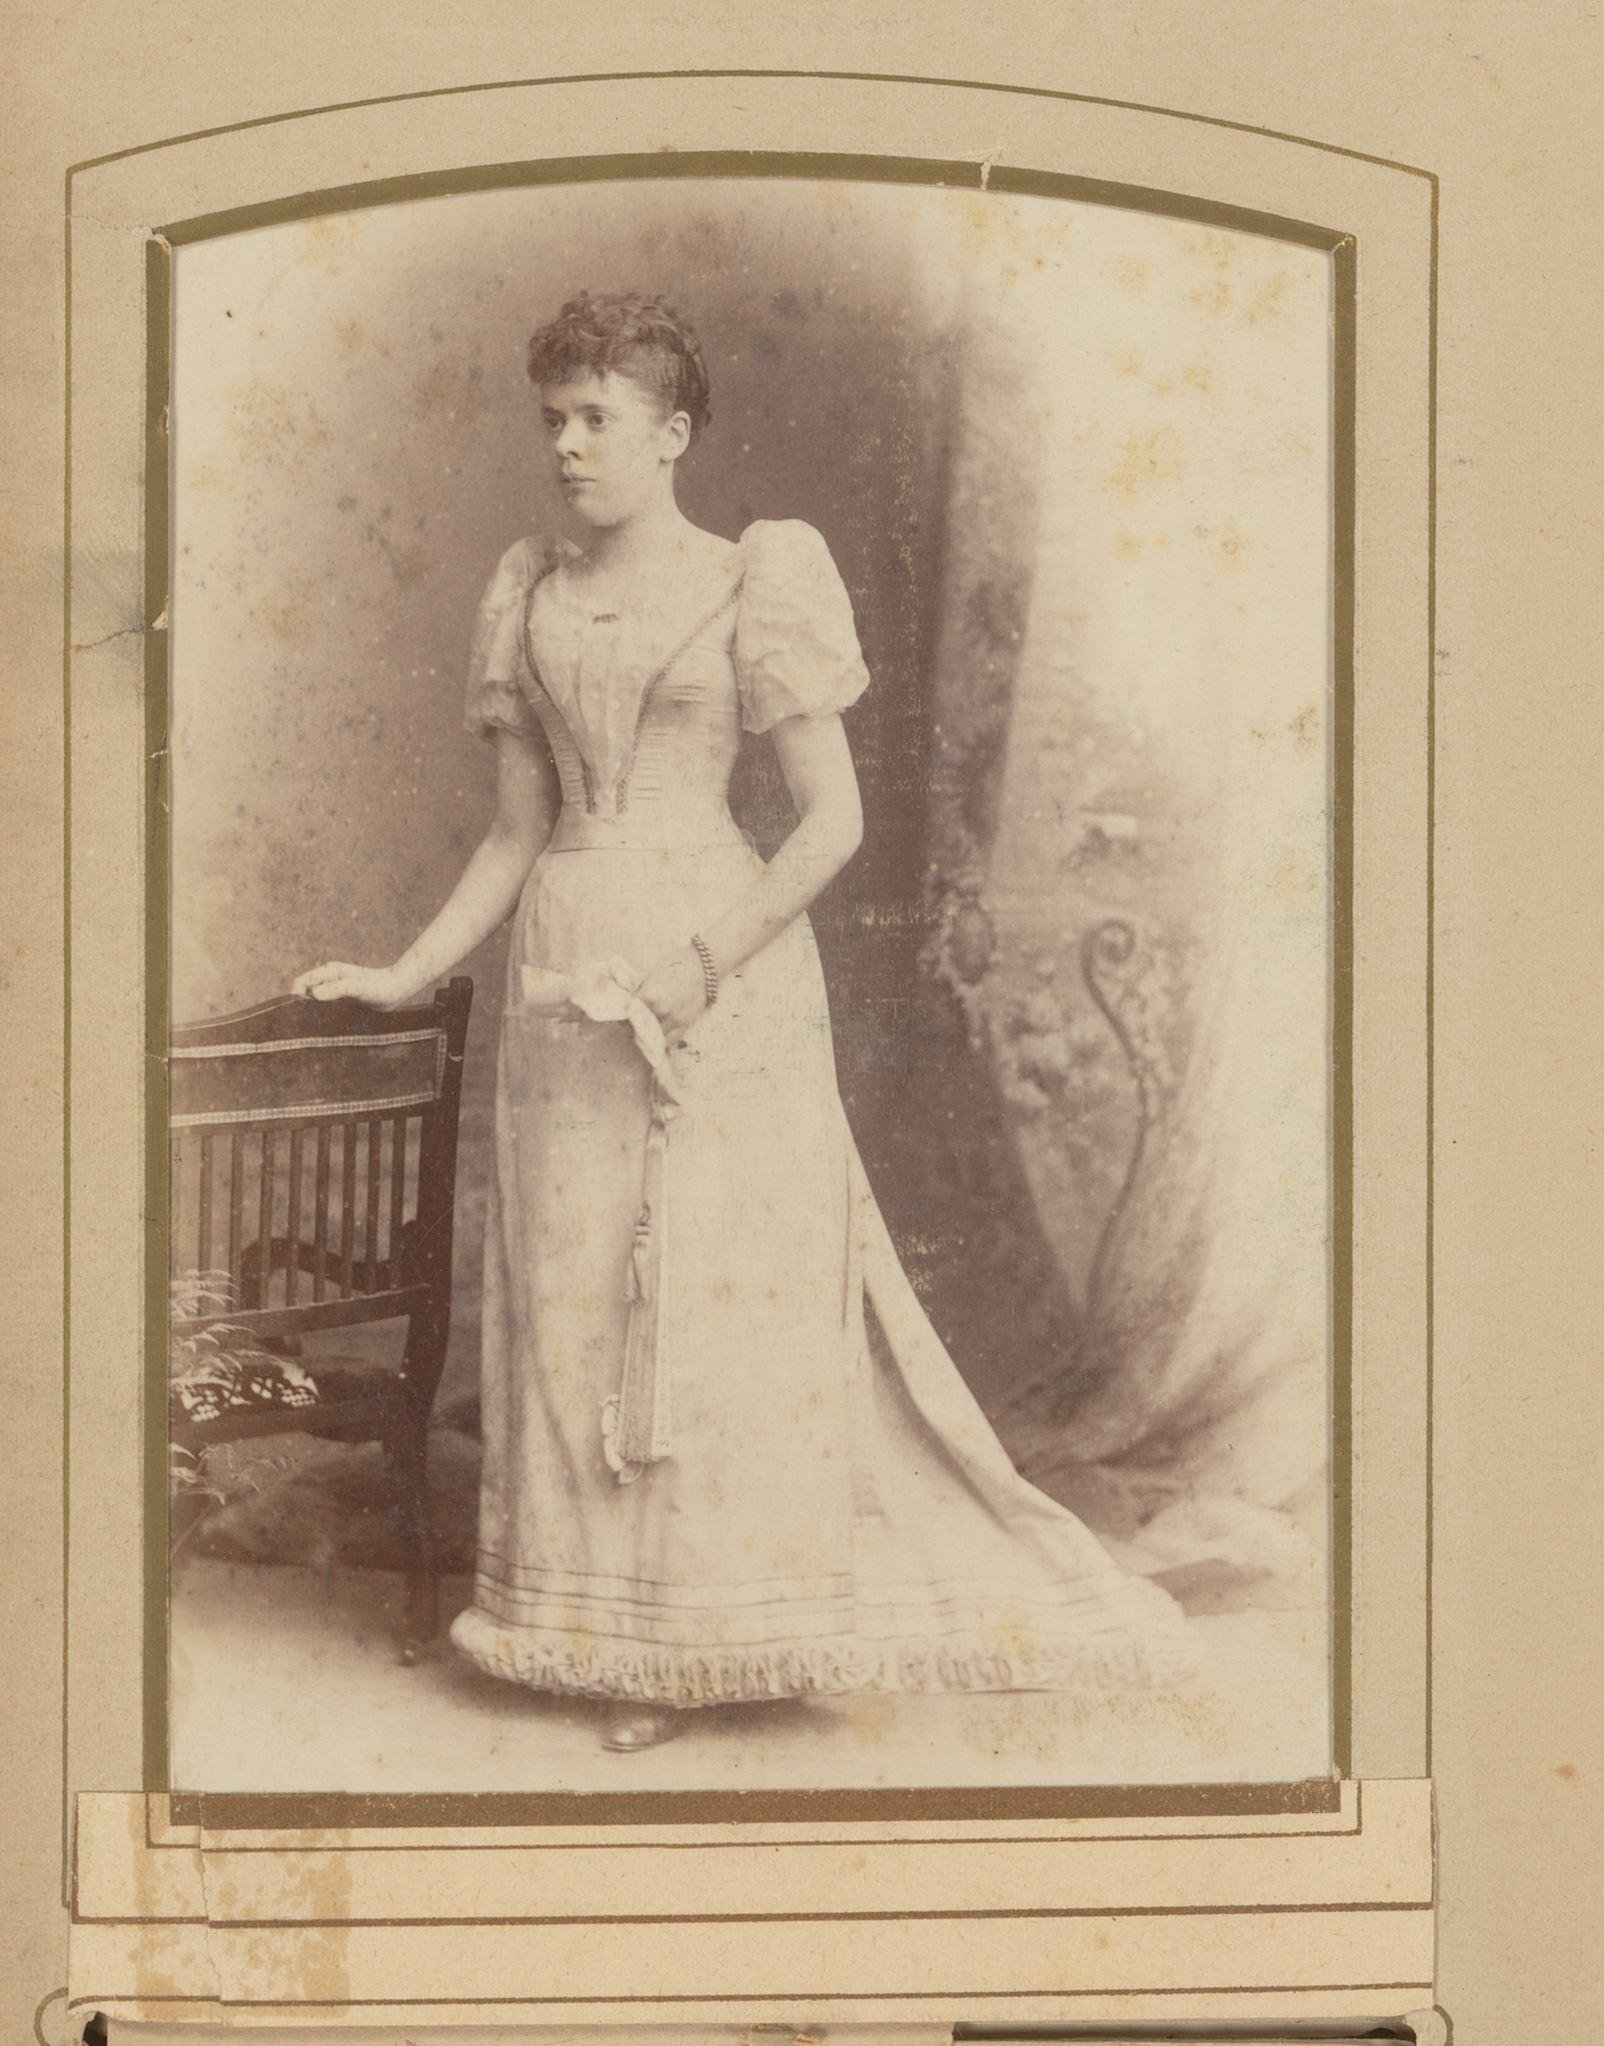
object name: album leaf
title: Portret van een vrouw, staand bij een stoel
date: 1893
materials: cardboard, photographic support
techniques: albumen print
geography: bayswater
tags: historical persons - bb - woman, standing figure - aa - female human figure, chair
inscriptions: annotation: ‘[...]/ [...] 1893’, inscription: ‘Miniature/ Painters/ Webster Bros/ 25, The Pavement,/ Clapham Common, s.w./ AND AT/ 4, Porchester Road,/ BAYSWATER. W./ No 6370’